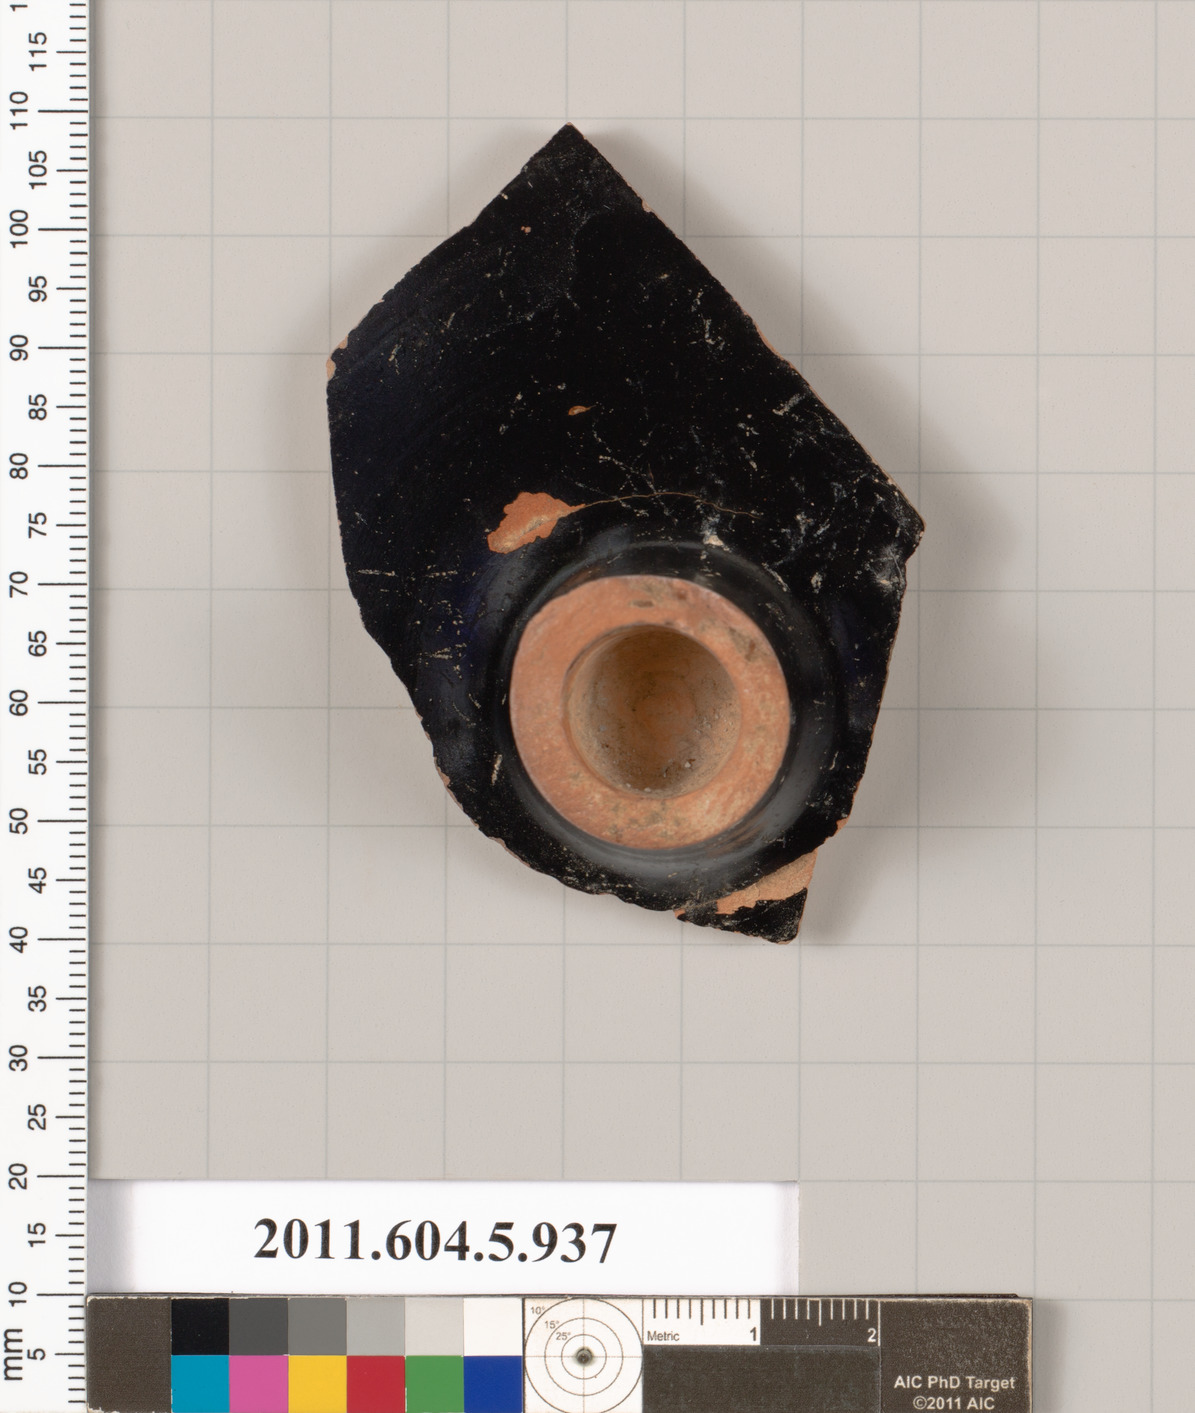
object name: kylix fragment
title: Terracotta fragment of a kylix (drinking cup)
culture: greek, attic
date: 600-401 BCE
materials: terracotta